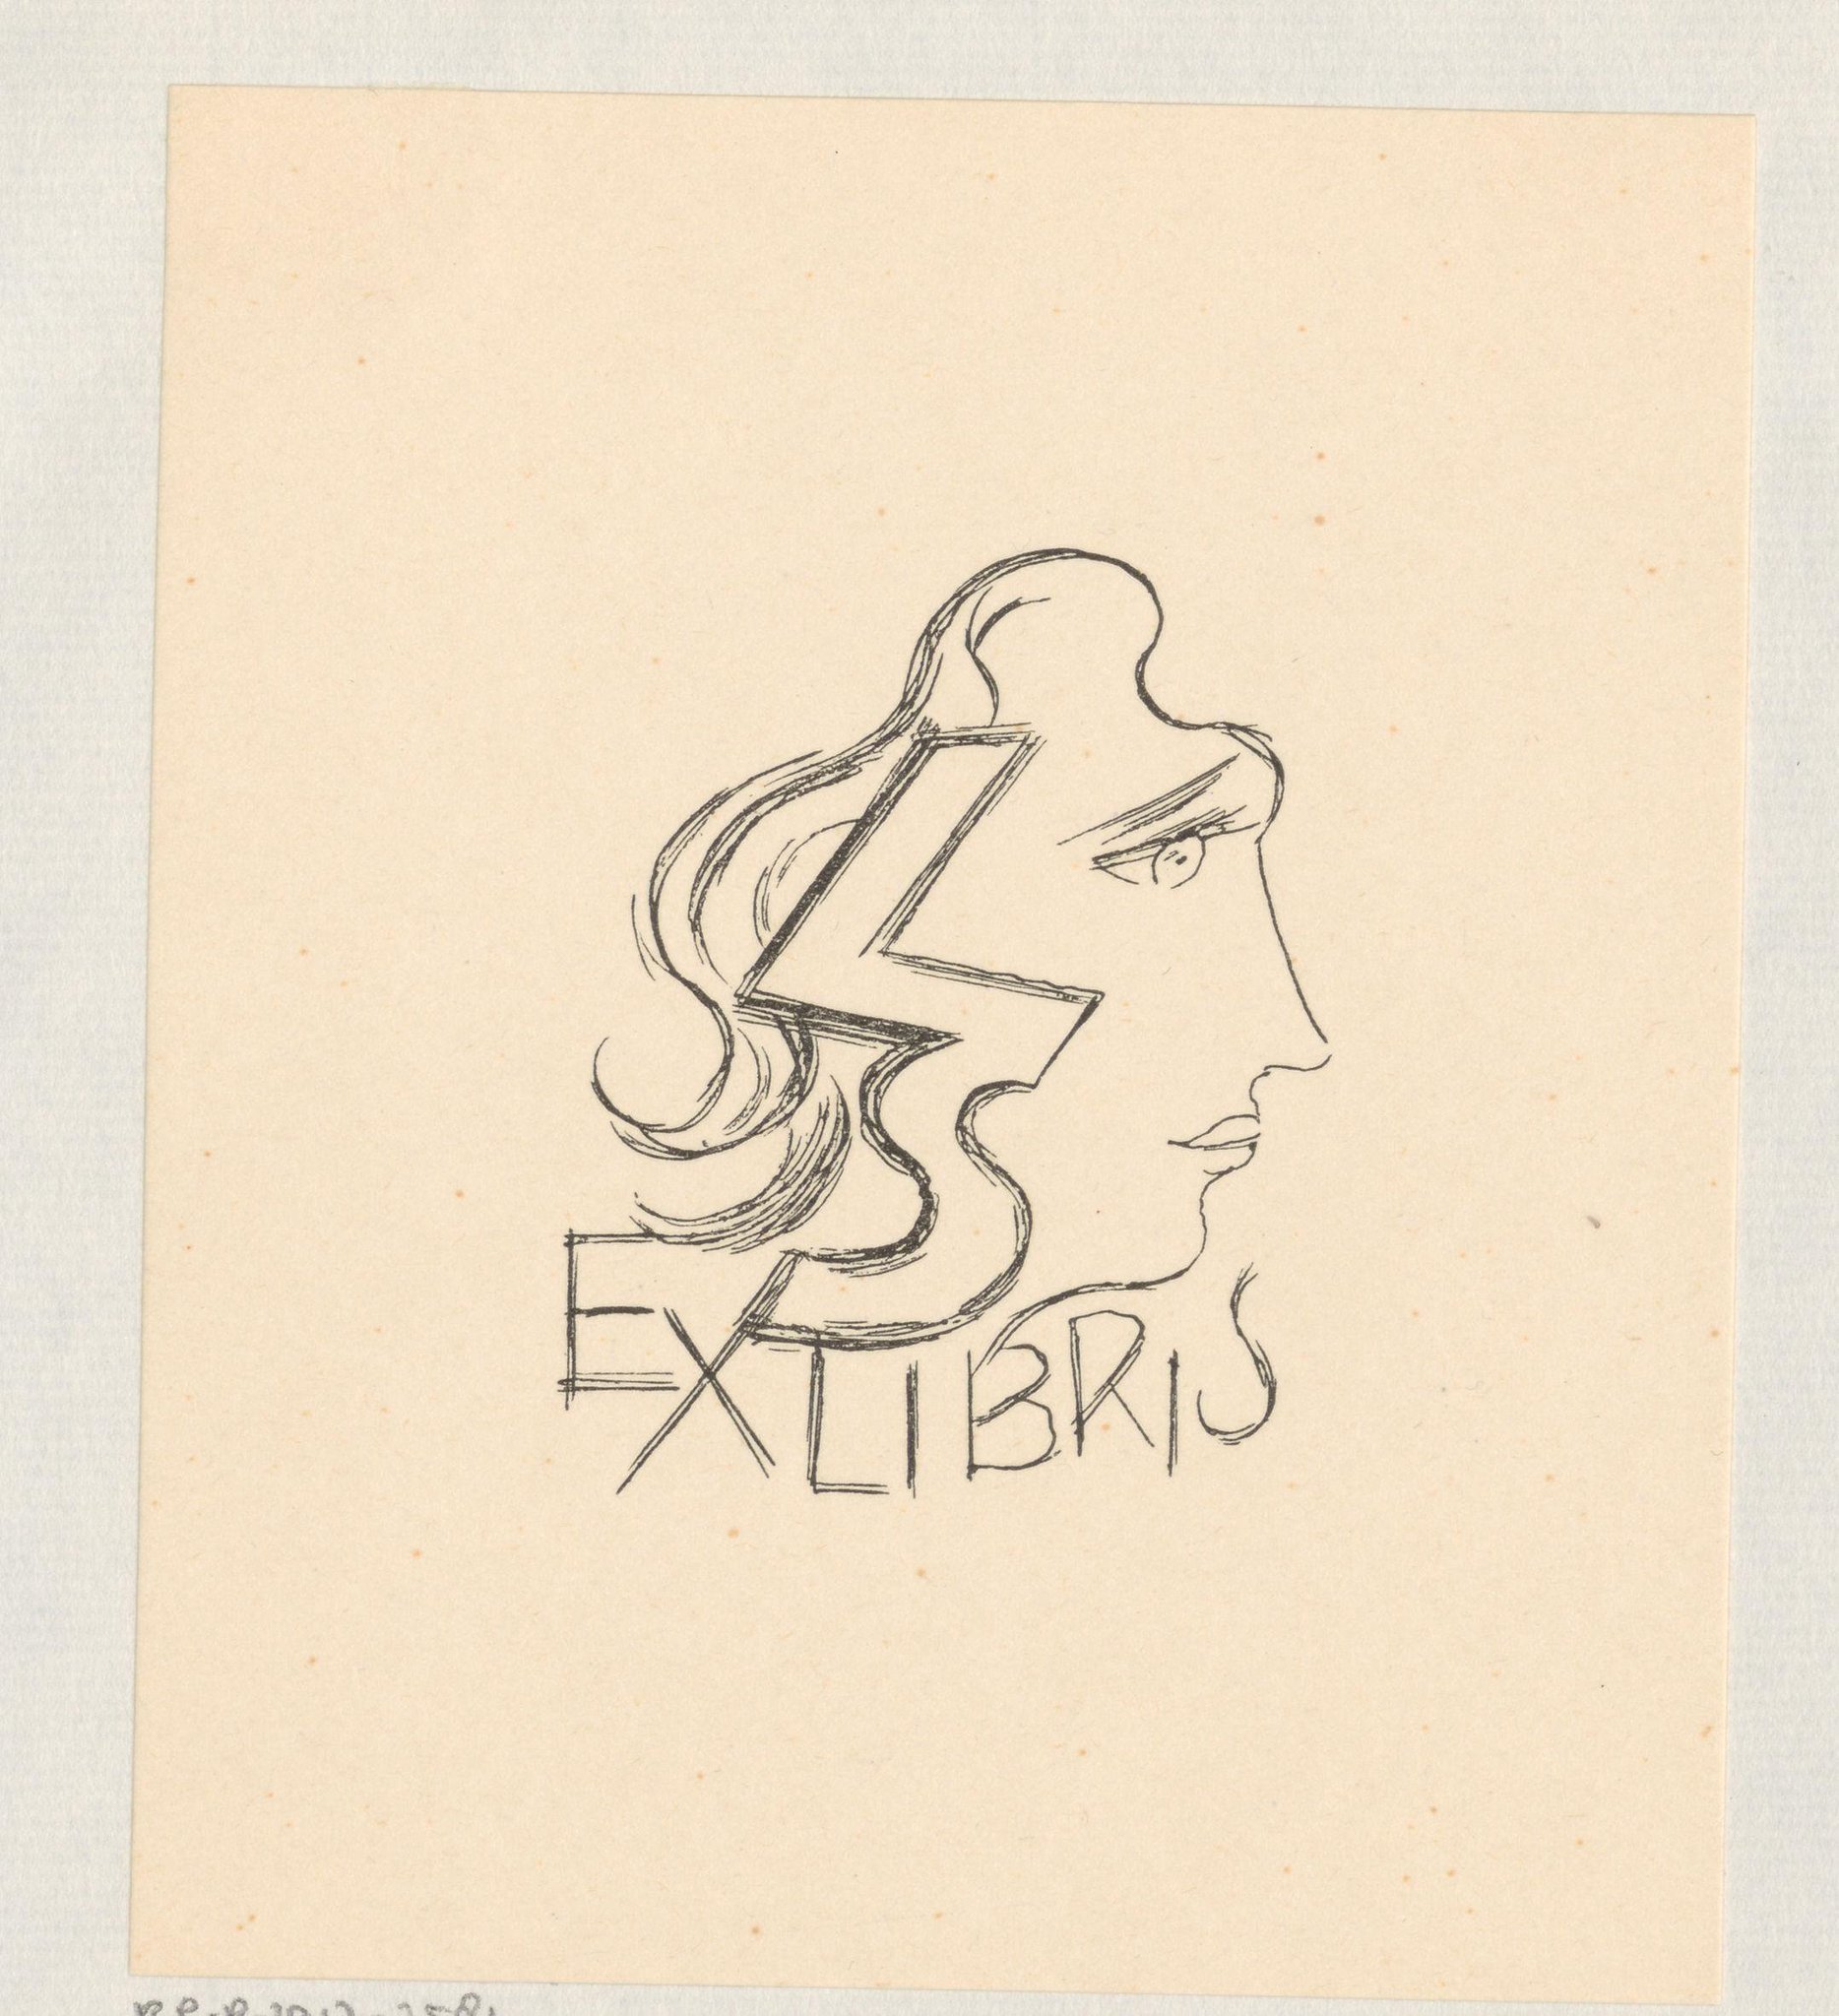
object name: bookplate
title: Ex libris van L.S.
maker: michel fingesten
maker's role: painter, print maker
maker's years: 1884-1943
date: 1894-1943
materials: paper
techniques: lithograph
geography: milan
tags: head turned sideways - aa - female human figure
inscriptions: workshop stamp: ‘Michel Fingesten / Milano’